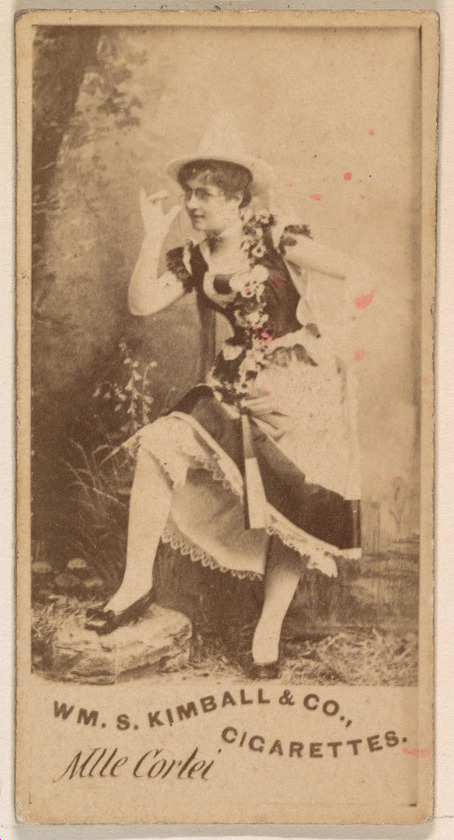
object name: photograph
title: Mlle Cortei, from the Actresses series (N203) issued by Wm. S. Kimball & Co.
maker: william s. kimball & company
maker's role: publisher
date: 1889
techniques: color lithograph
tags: portraits,women,actresses